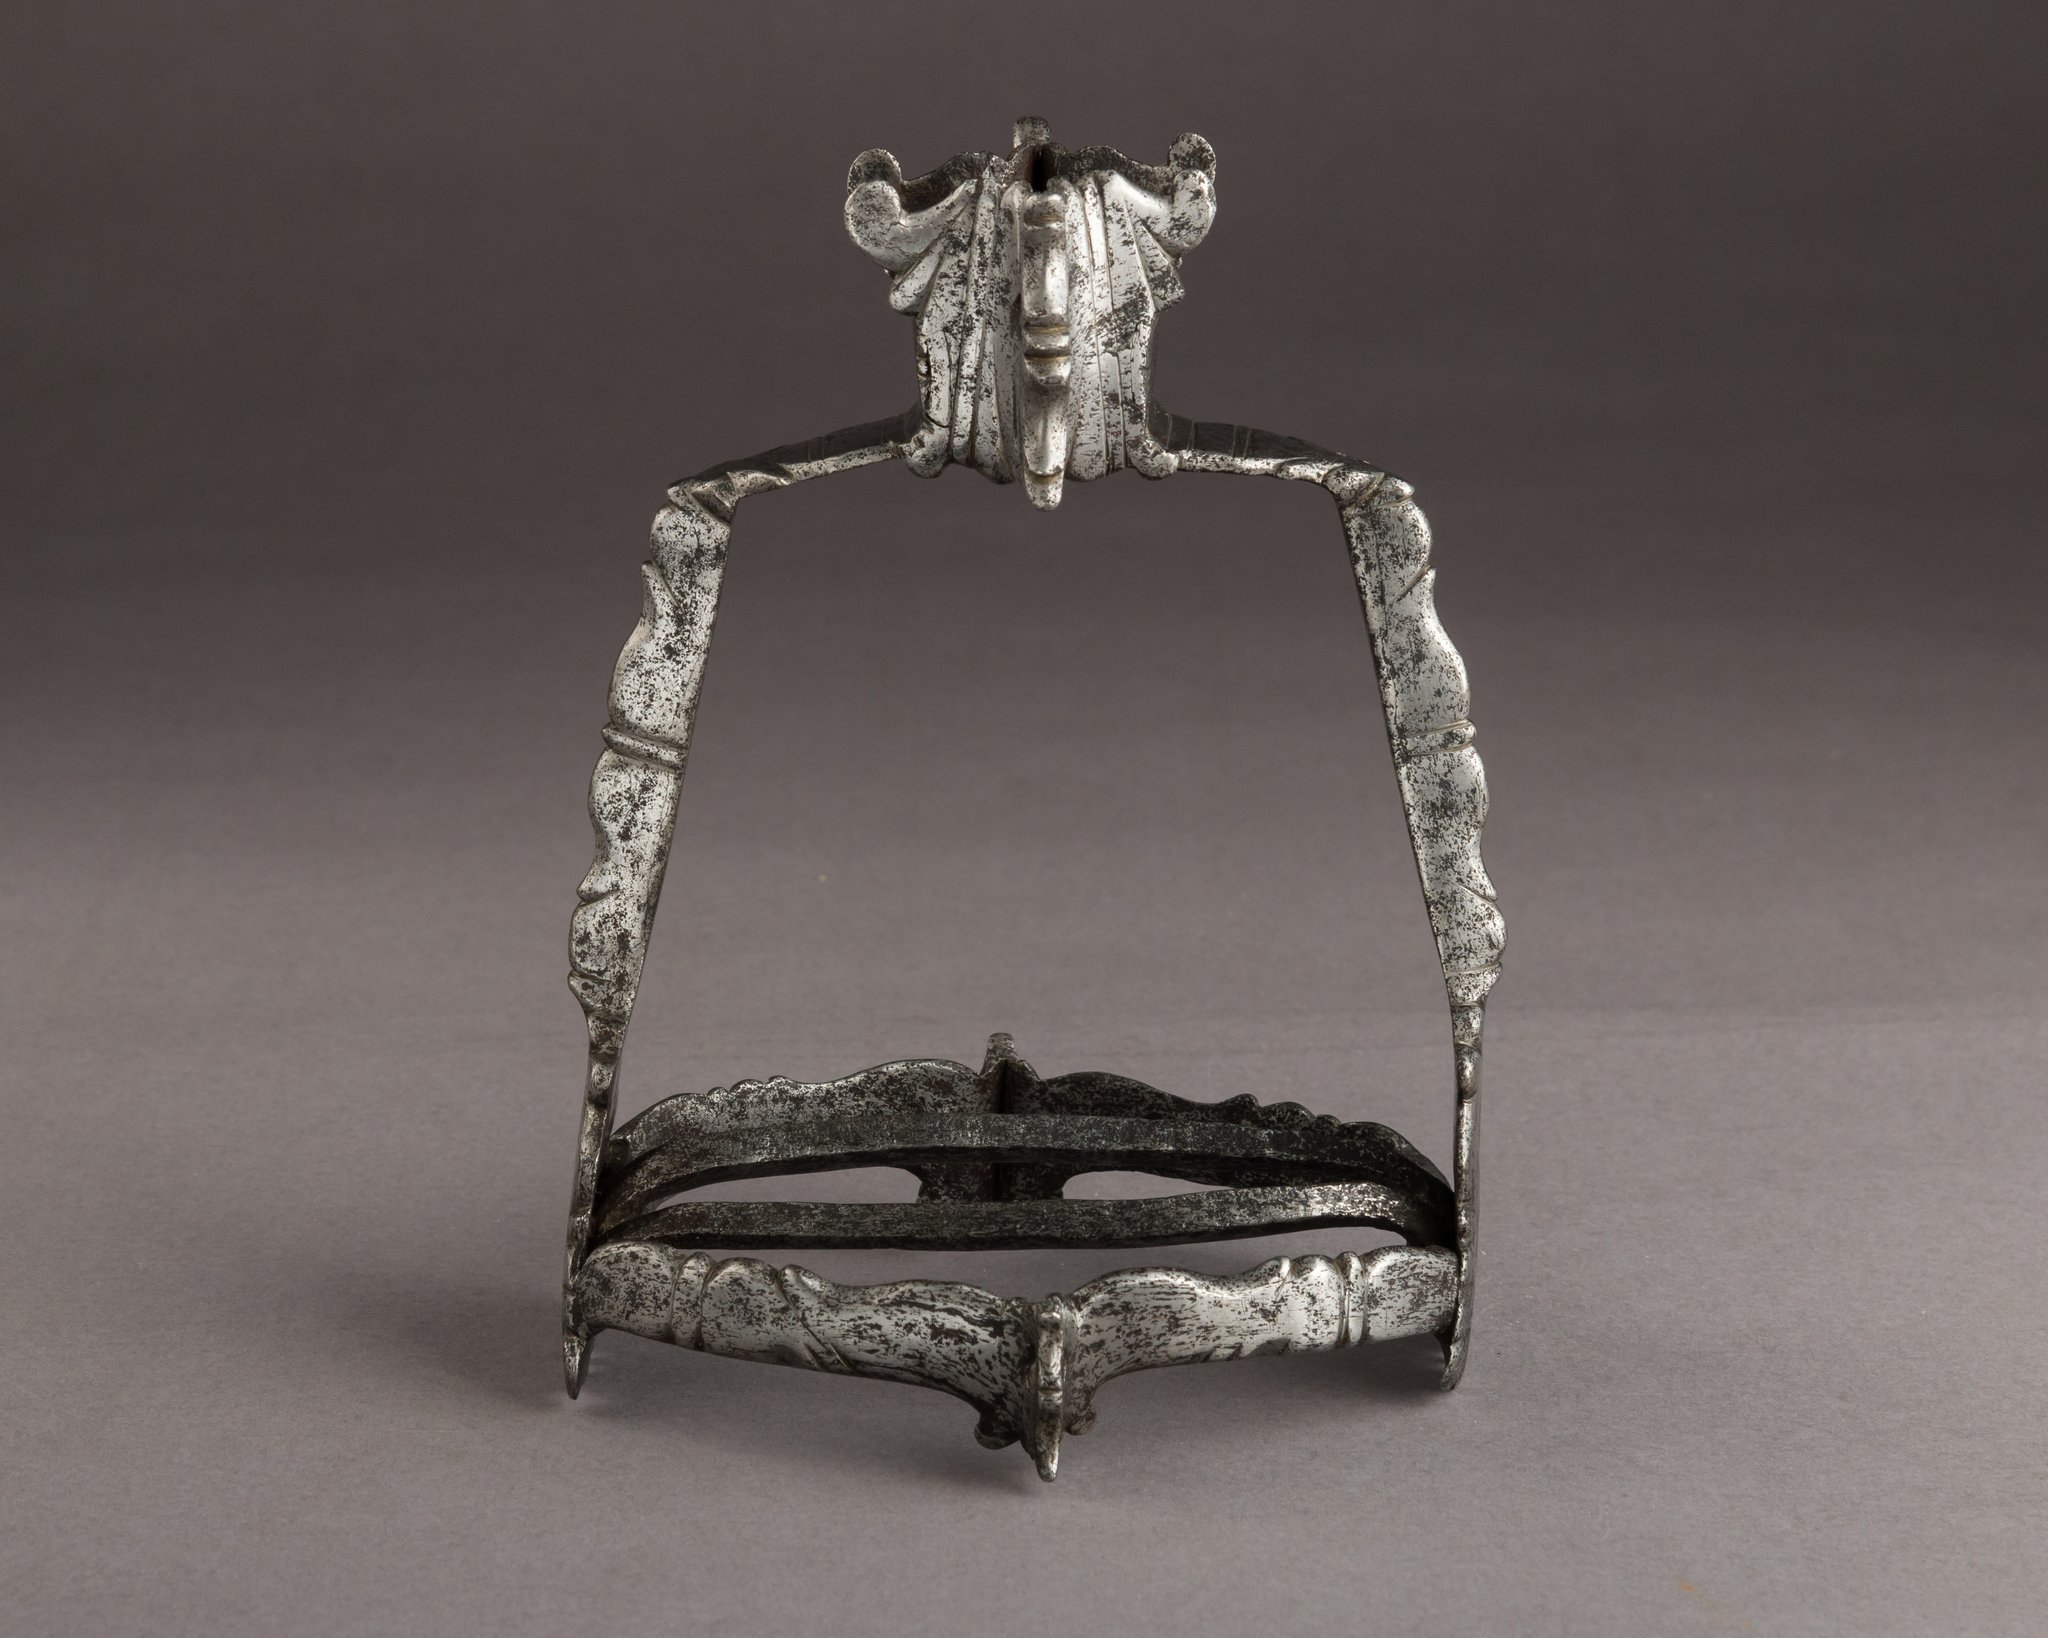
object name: stirrup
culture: german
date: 1667-1700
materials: metal alloy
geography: germany